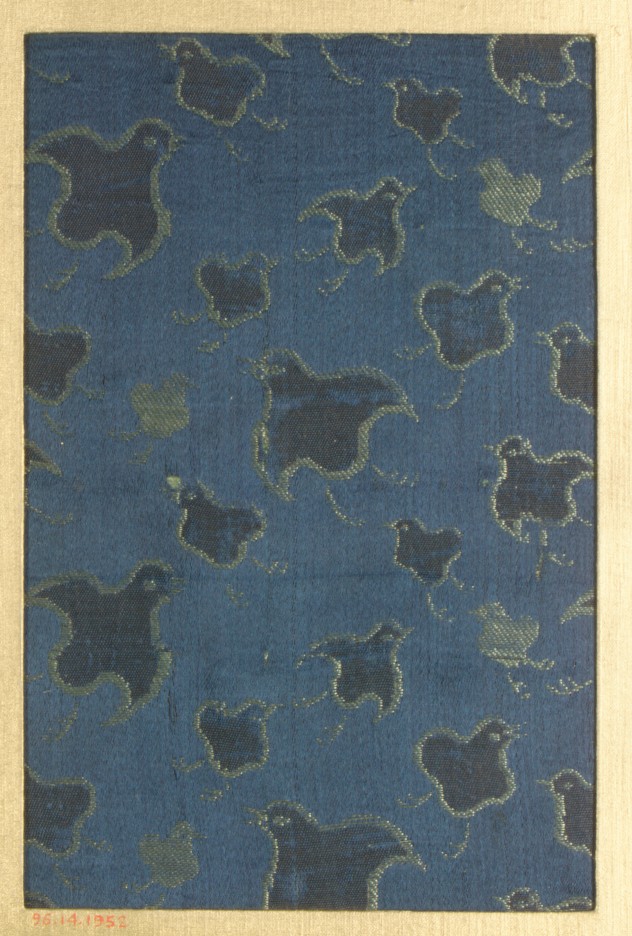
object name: piece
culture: japanese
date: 1701-1900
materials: silk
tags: birds